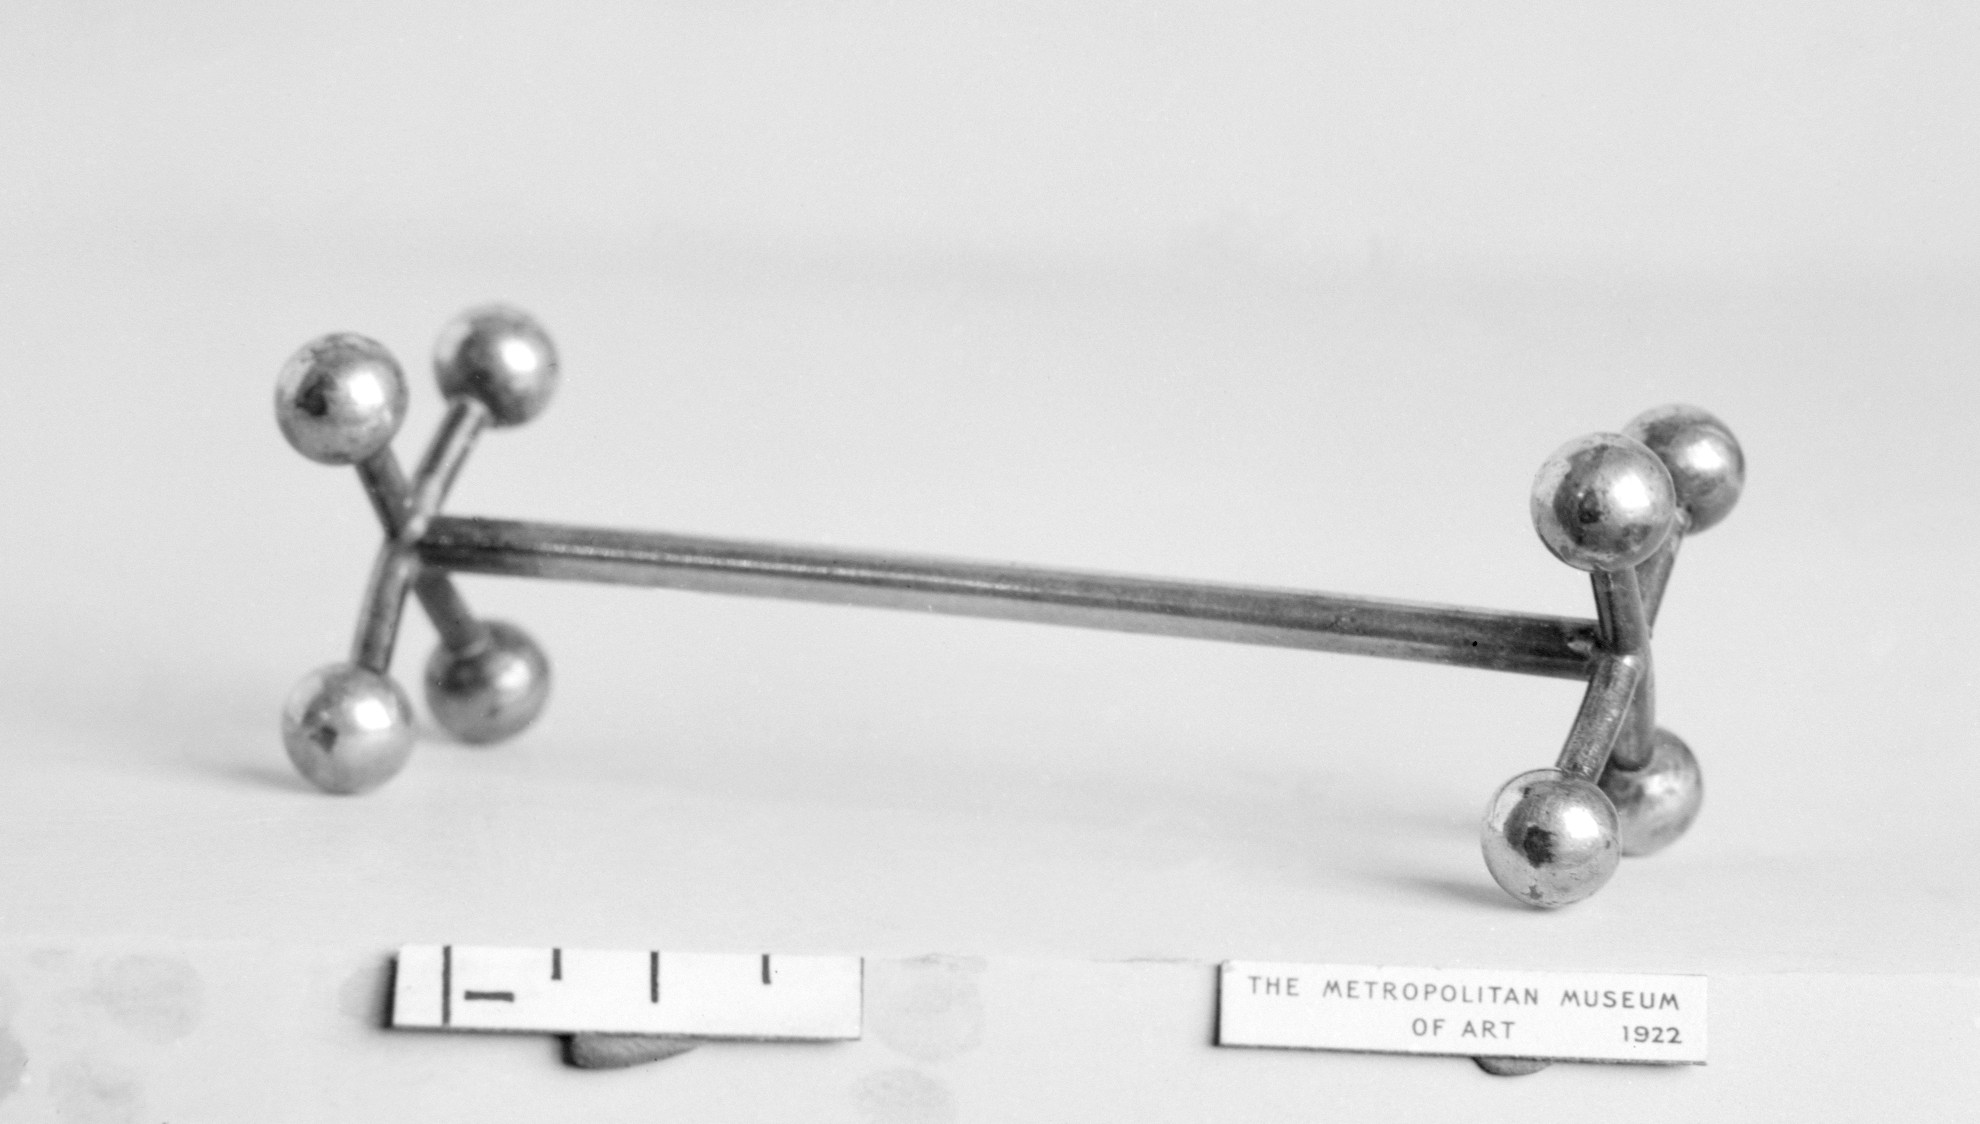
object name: knife rest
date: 1790-1810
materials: metal